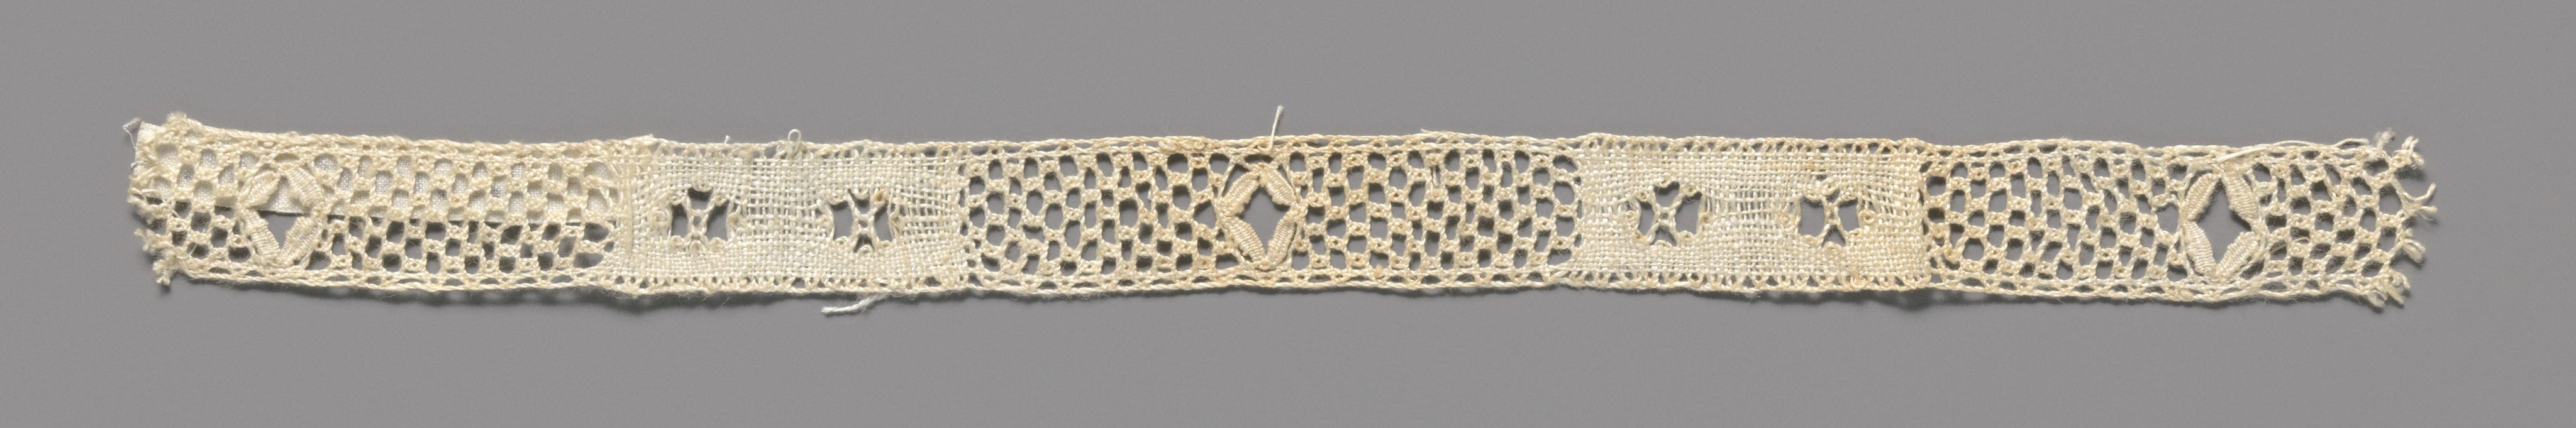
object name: strip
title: Tussenzetsel met opengewerkt ruit in traliegrond en opengewerkte cirkels in linnenwerk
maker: Anonymous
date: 1925-1937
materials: linen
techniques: lace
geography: como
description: Tussenzetsel van naturelkleurige kloskant. Het zich herhalende patroon bestaat uit een traliegrond met opengewerkt ruit. Elke zijde van de ruit bestaat uit een spitsovaal gemaakt in vormslag. De traliegrond wordt afgewisseld door een gedeelte dat geheel is gemaakt in linnenslag. In het linnenwerk staan twee opengewerkte cirkels, elk gevuld met één vetergatslag gevormd door twee staande paren. Boven- en onderzijde van de strook zijn recht afgewerkt.